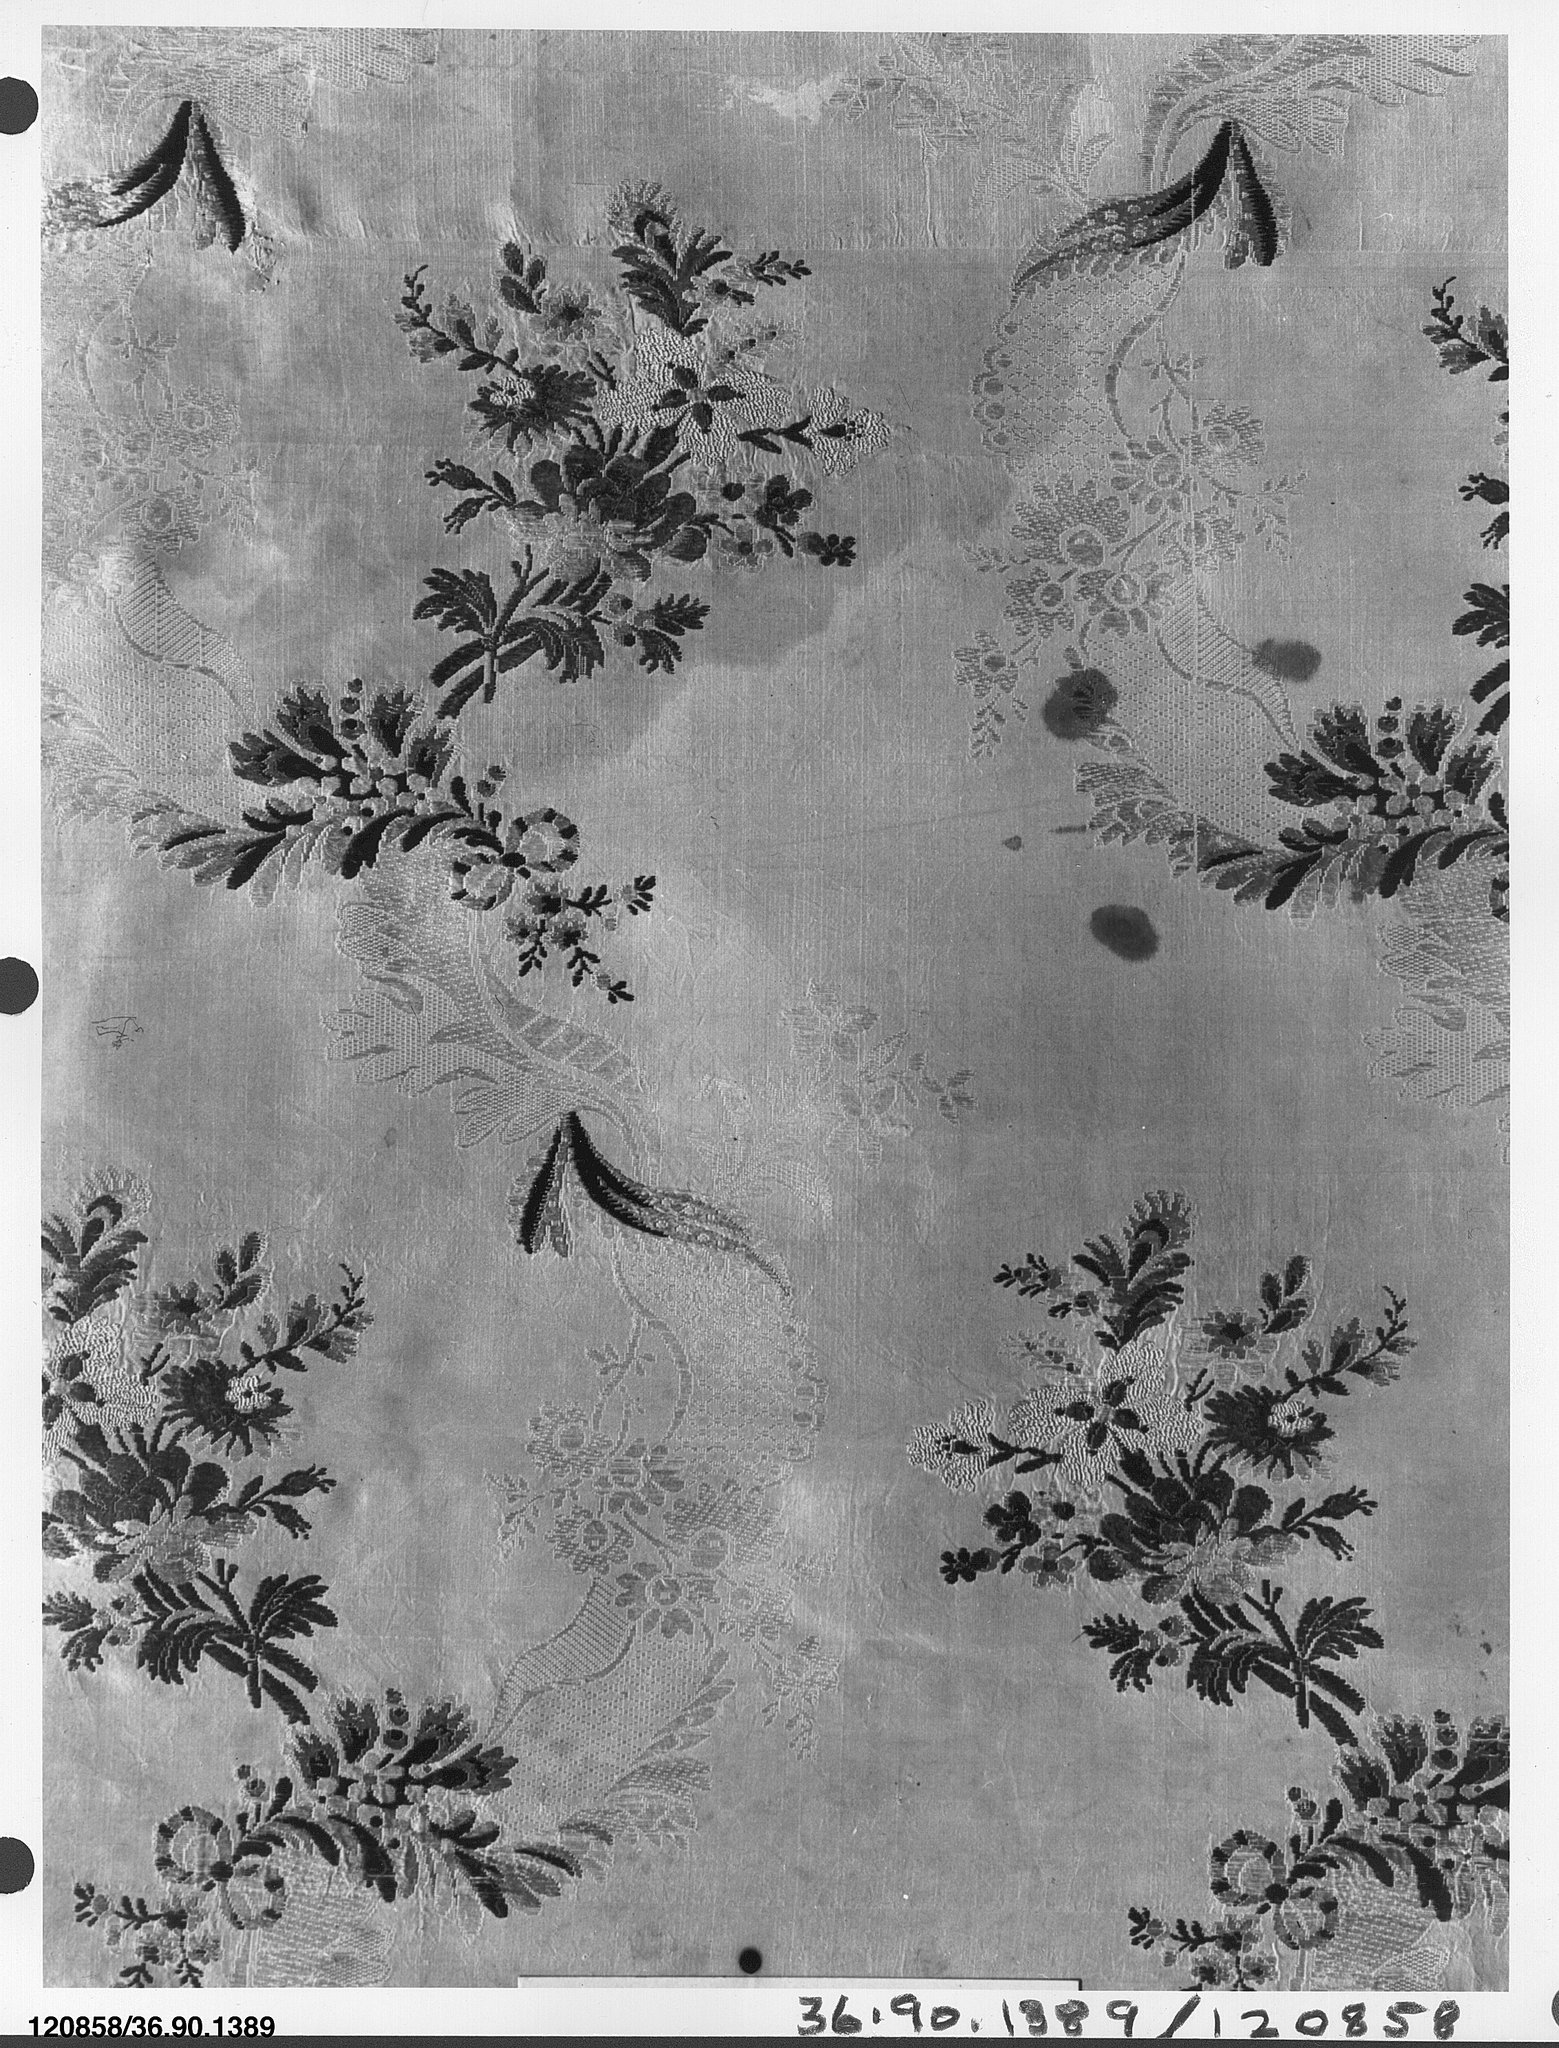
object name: piece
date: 1750-1760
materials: silk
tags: flowers,leaves